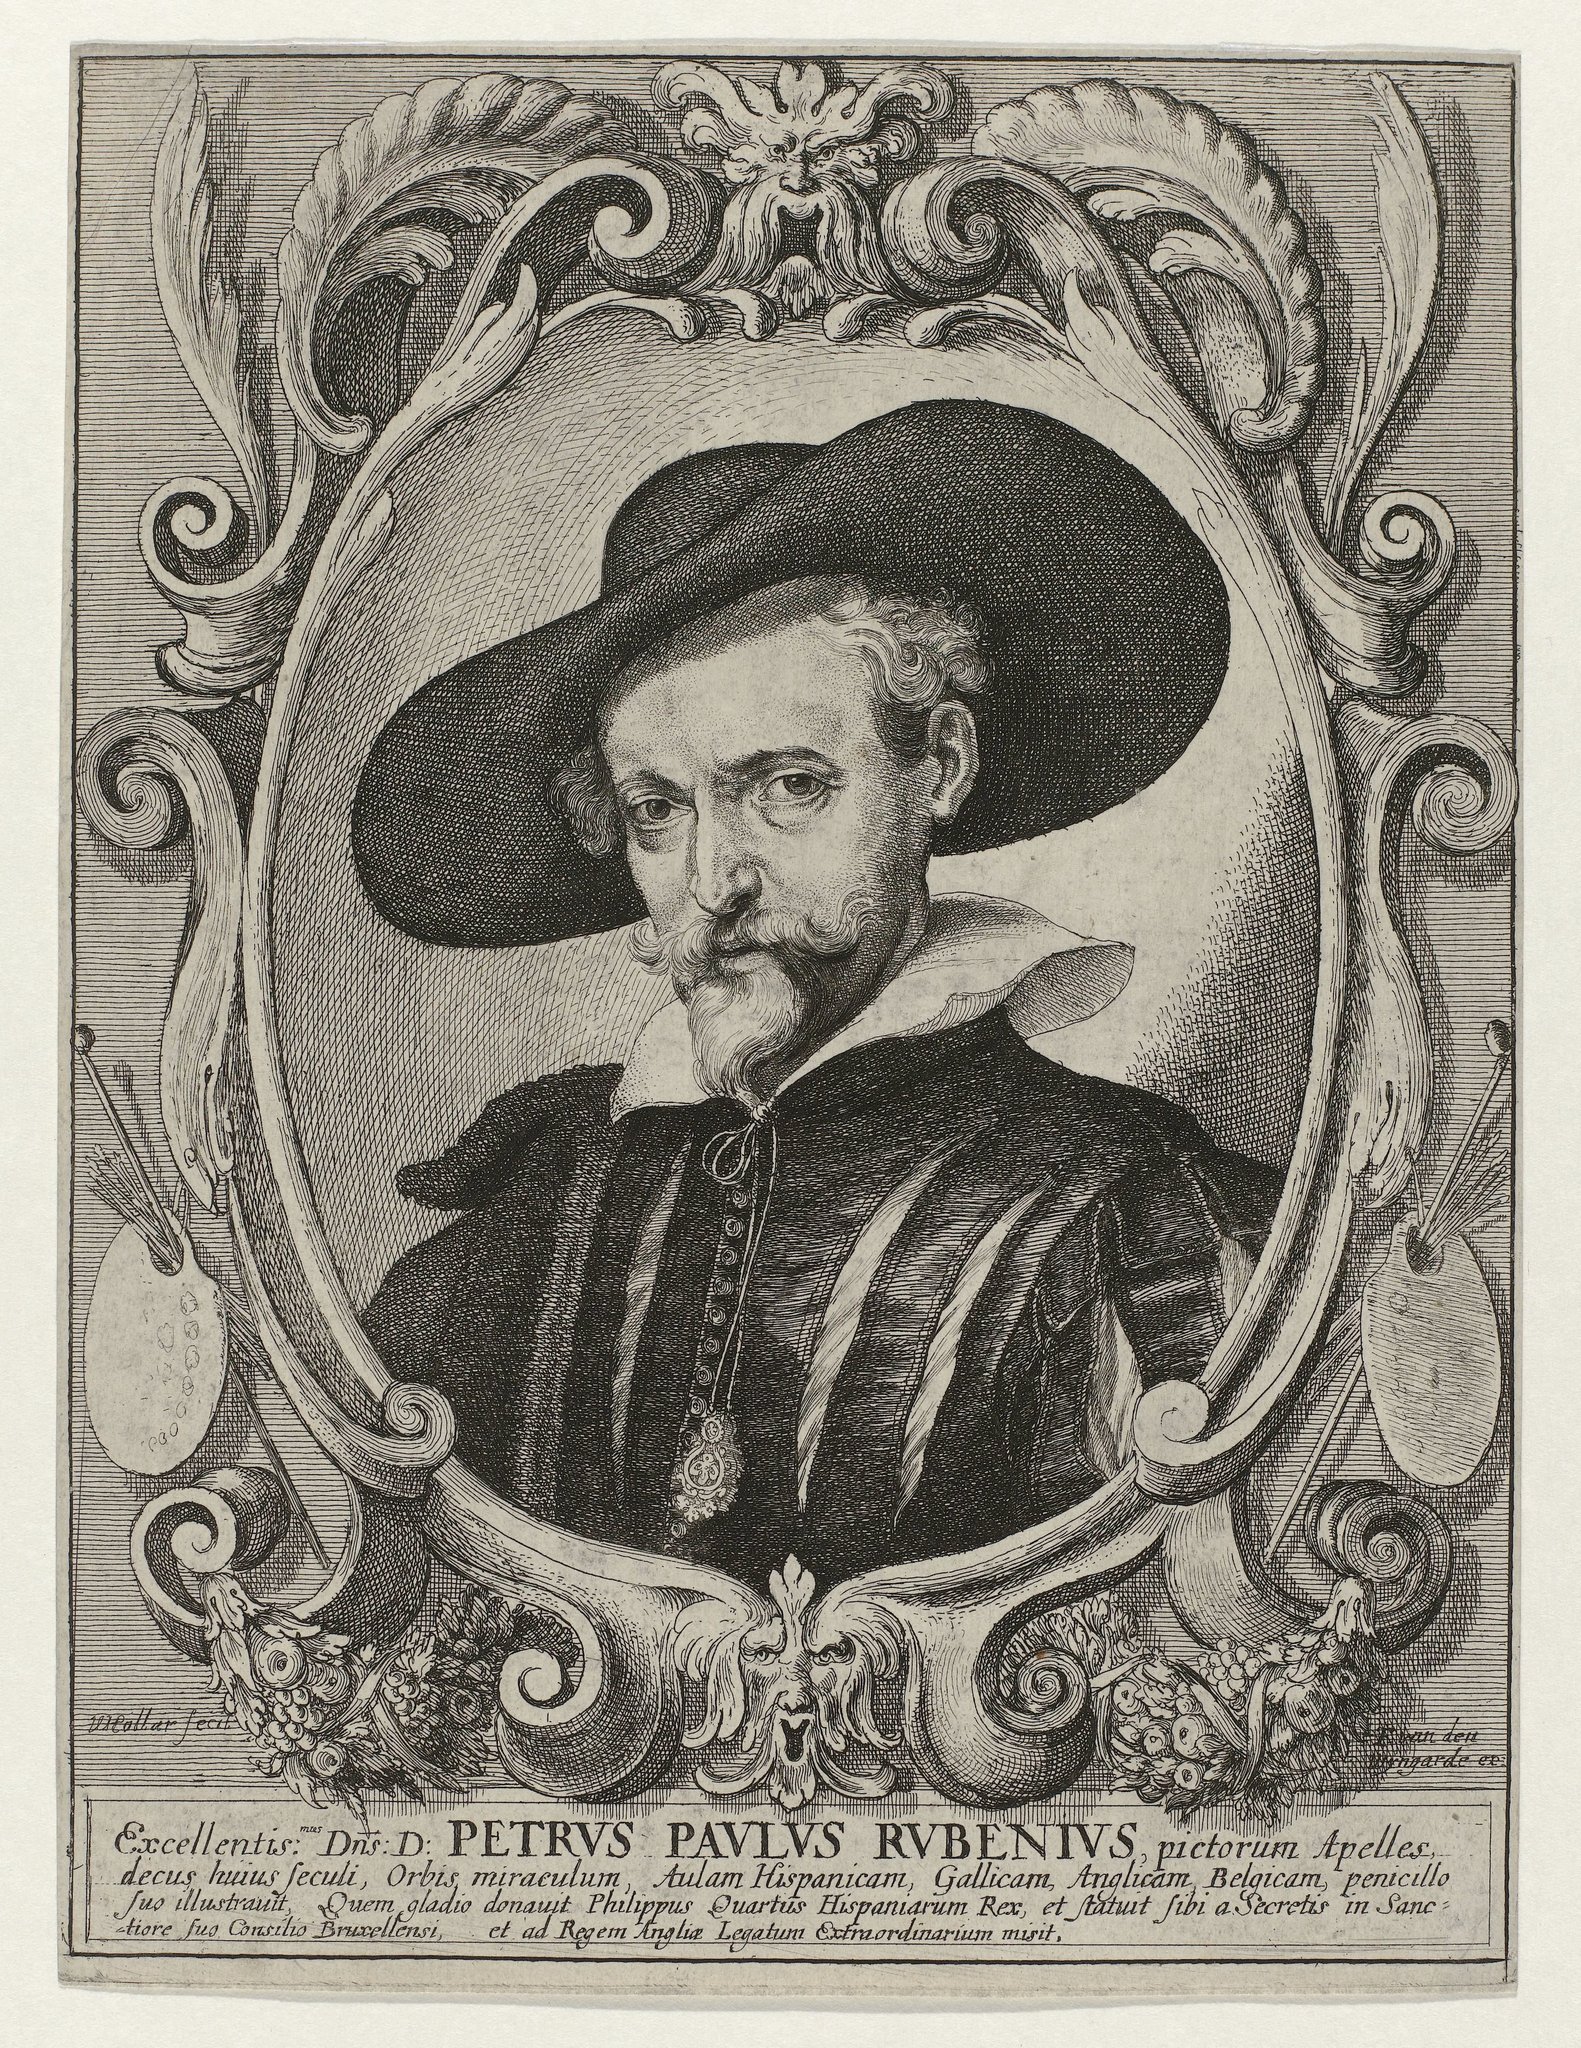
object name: print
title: Portrait of Peter Paul Rubens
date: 1644-1652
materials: paper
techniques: etching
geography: antwerp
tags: antwerp, painter, print maker, draughtsman, peter paul rubens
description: During his career, Wenceslaus Hollar etched nearly 500 portraits. Most of them were based on paintings by artists such as Holbein and Van Dyck. For his portrait of Rubens, however, Hollar did not look at Rubens’ painted self-portrait, but at an engraved copy. The bust and caption were rendered minutely and to the letter. The lavish decorative border was Hollar's own invention.